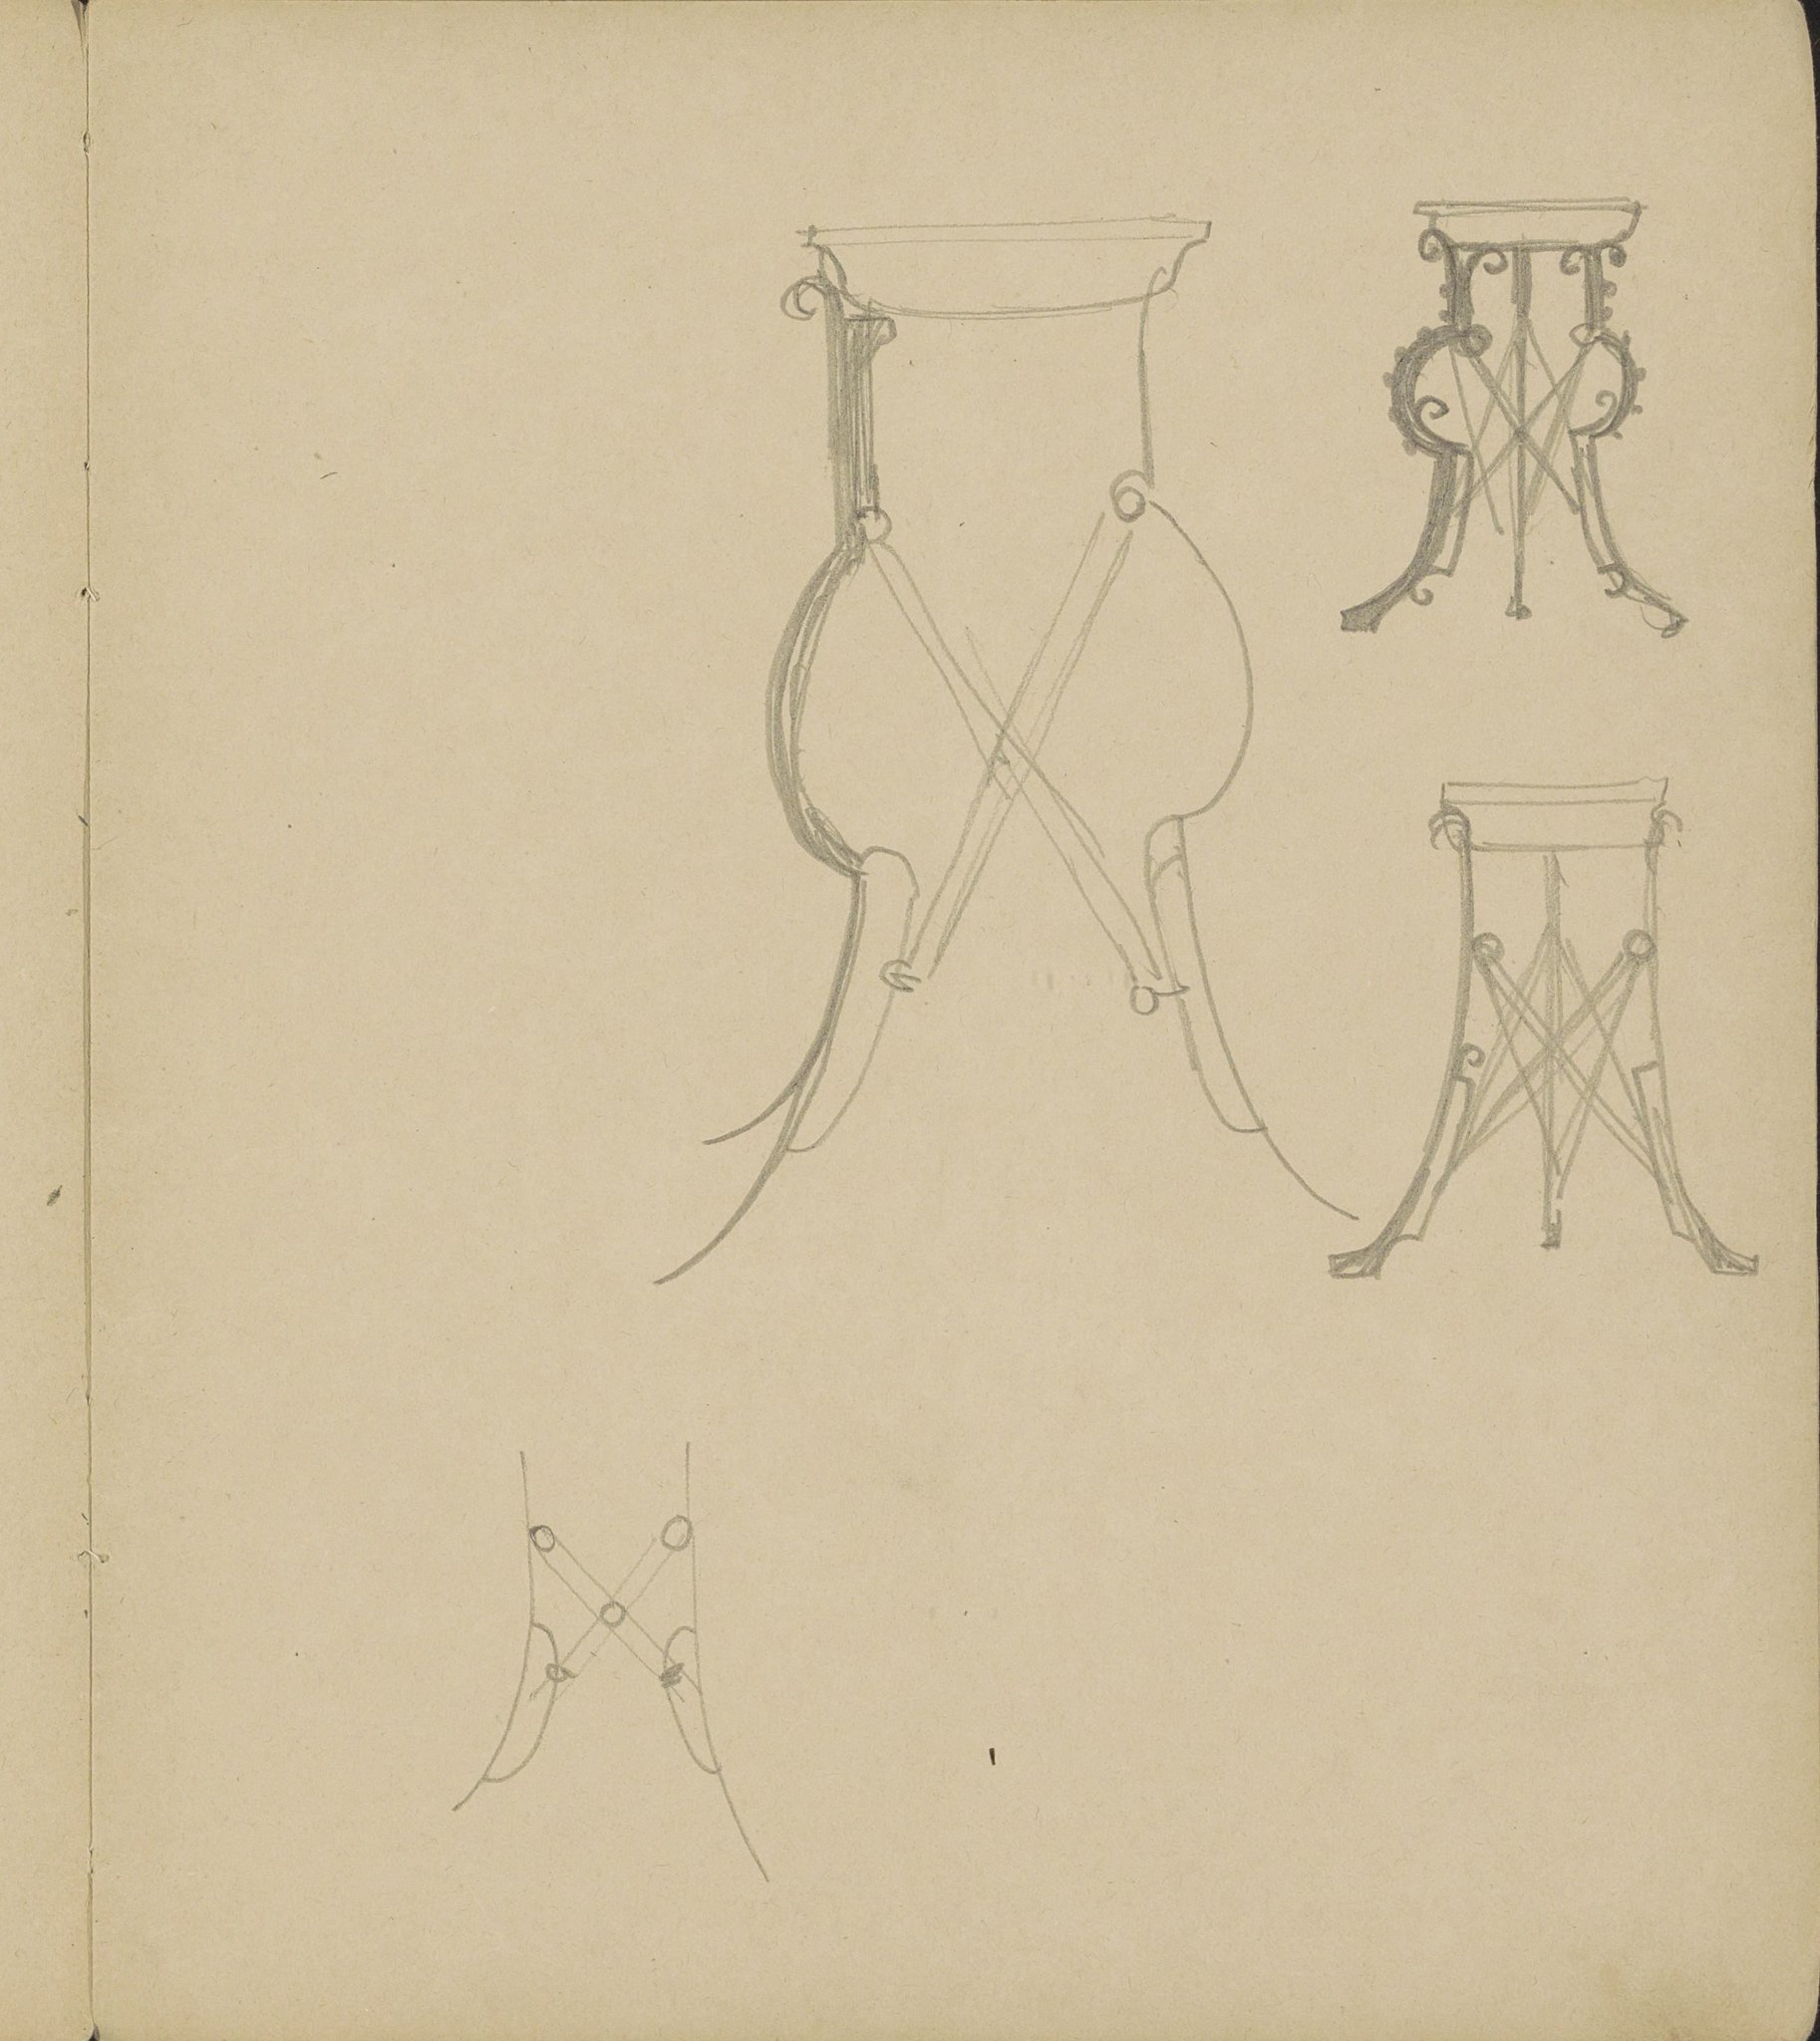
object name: sketchbook leaf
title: Ontwerpen voor het onderstel van een doopvont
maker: carel adolph lion cachet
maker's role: draughtsman, print maker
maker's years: 1864-1945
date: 1905-1906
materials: paper, pencil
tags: baptismal font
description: Blad 25 recto uit een schetsboek met 30 bladen.